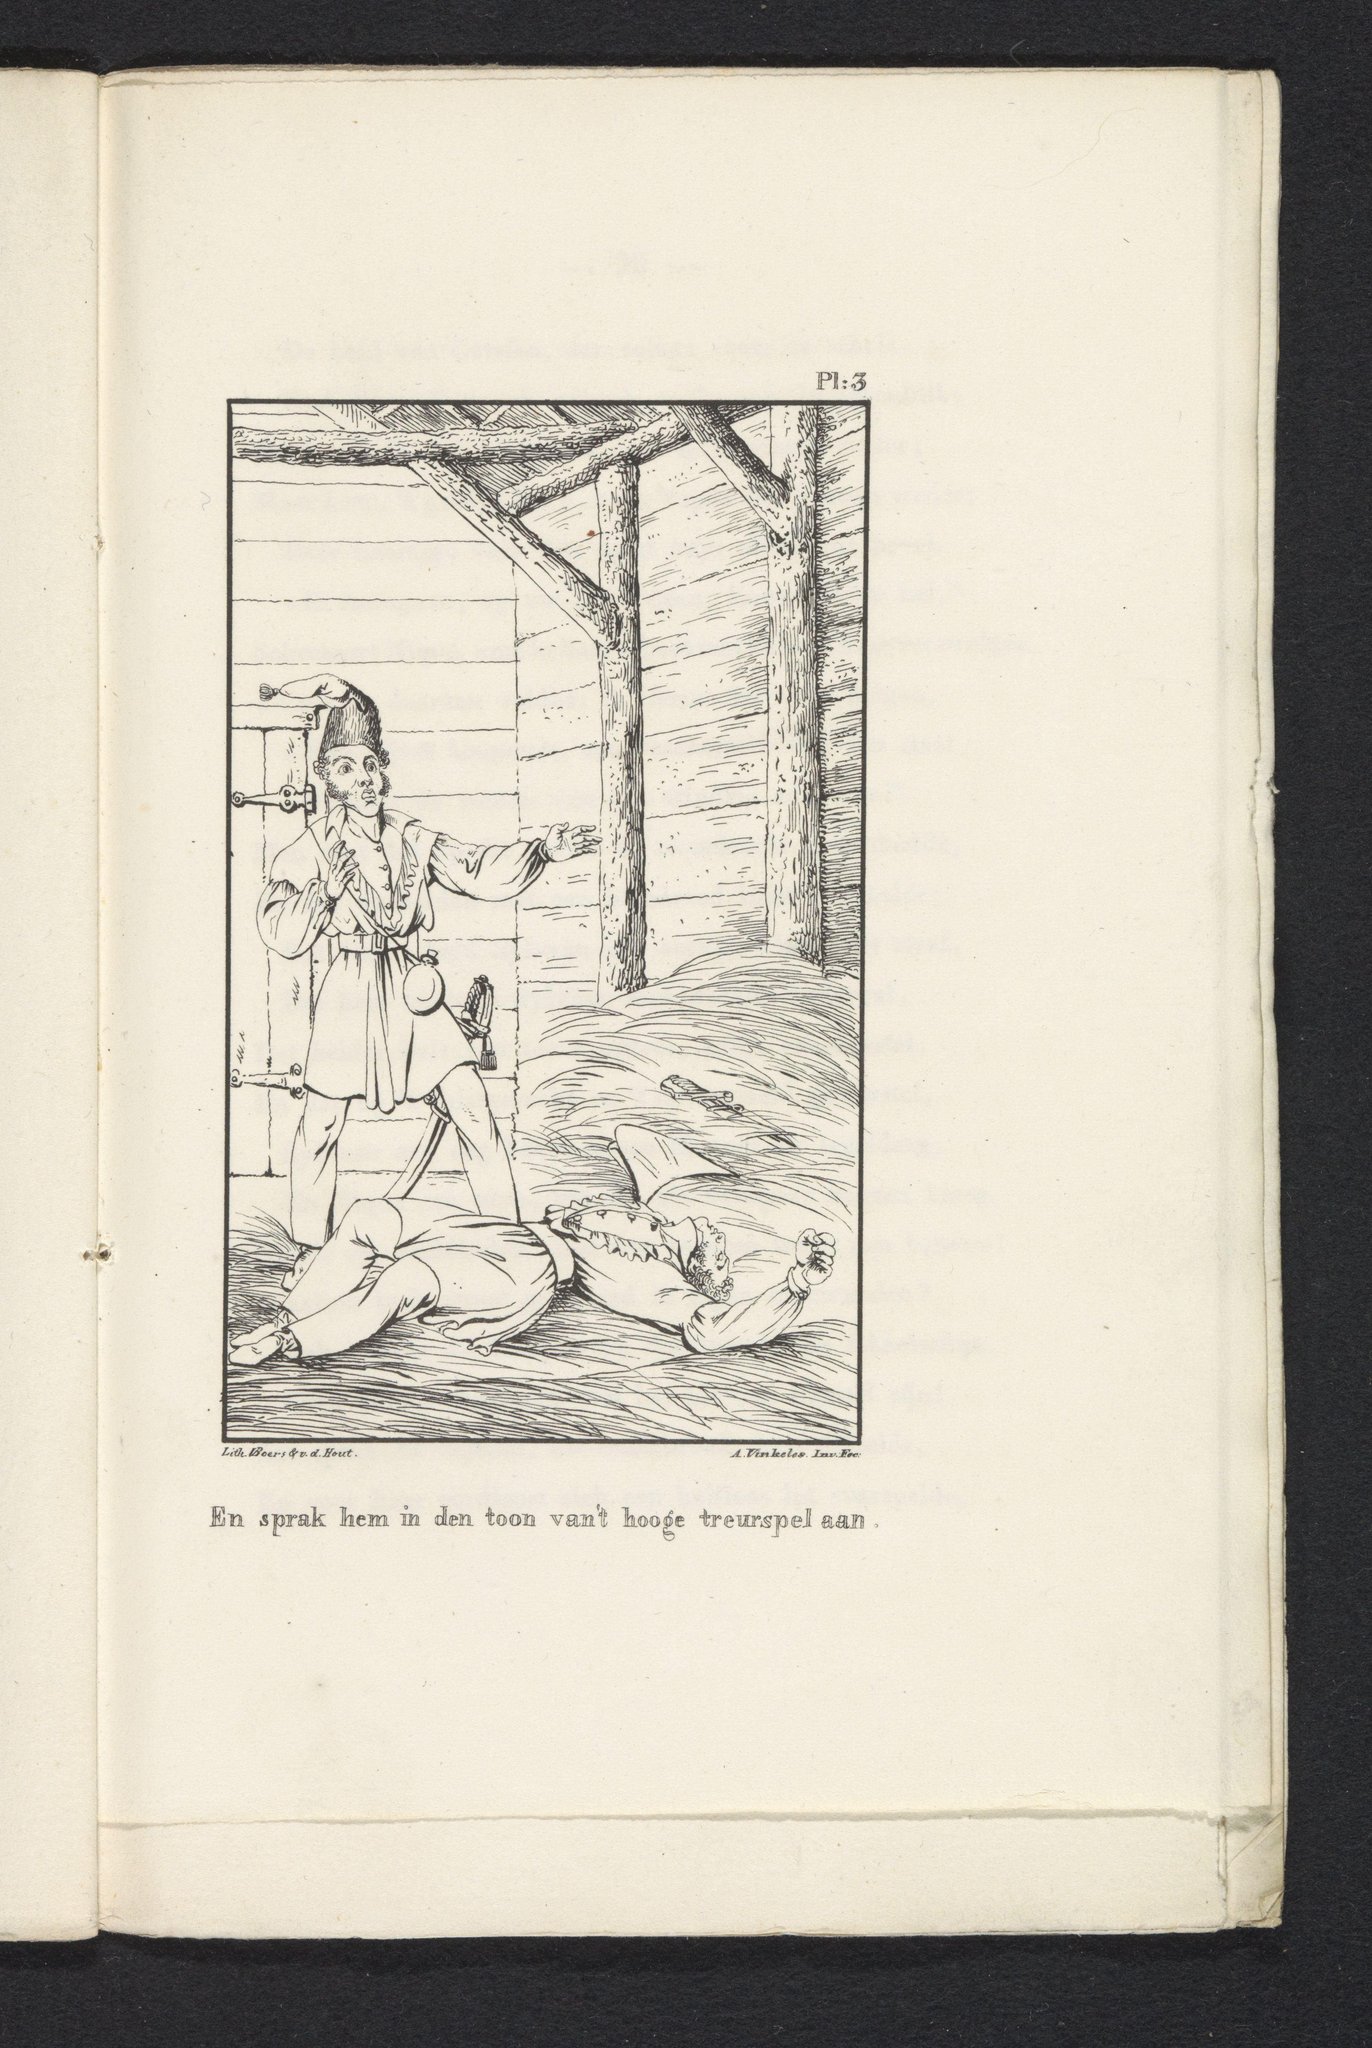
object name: cartoon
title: En sprak hem in den toon van 't hooge treurspel aan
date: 1832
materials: paper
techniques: lithograph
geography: netherlands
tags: fainting, swooning, liège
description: De leider van de groep Luikenaren valt verslagen in het stro als het Nederlandse leger Leuven binnen trekt. Spotprent als illustratie in een heldenzang over de tocht van de tachtig Luikenaren naar Tervuren op 6 september 1830.